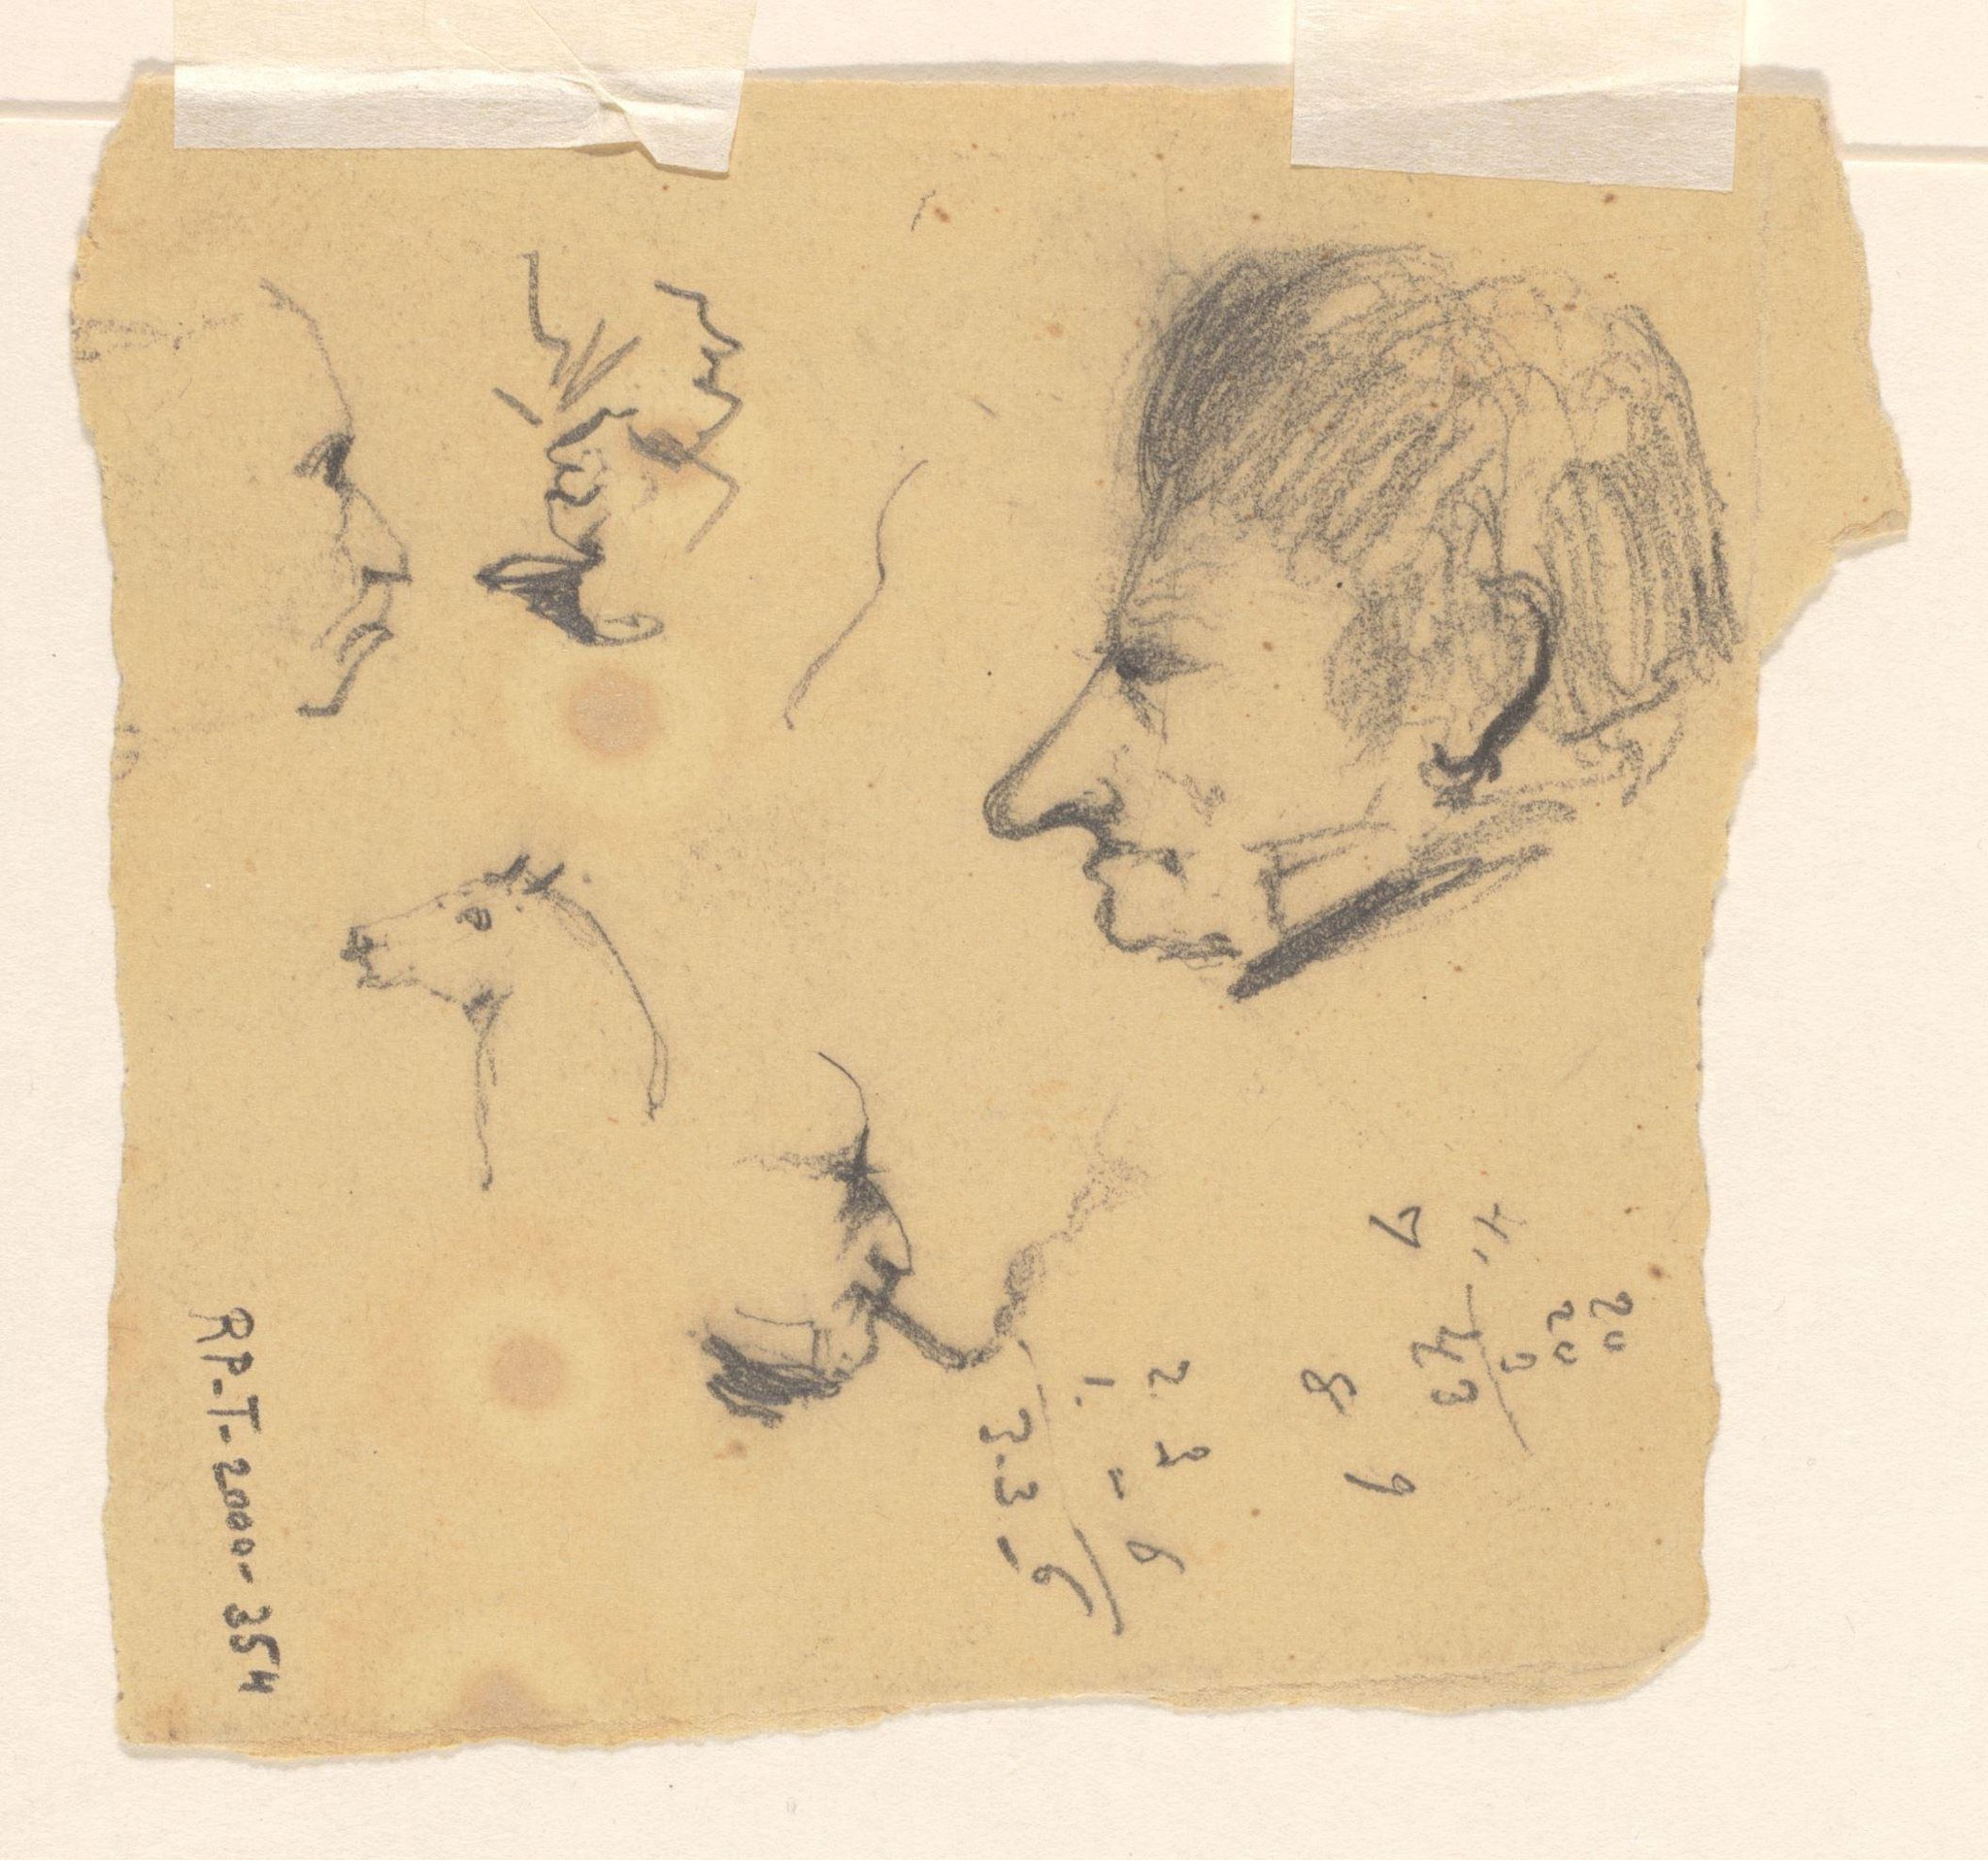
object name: drawing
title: Koppen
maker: johannes tavenraat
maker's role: draughtsman, painter, print maker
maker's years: 1809-1881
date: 1840-1880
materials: paper, pencil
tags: caricatures (human types)